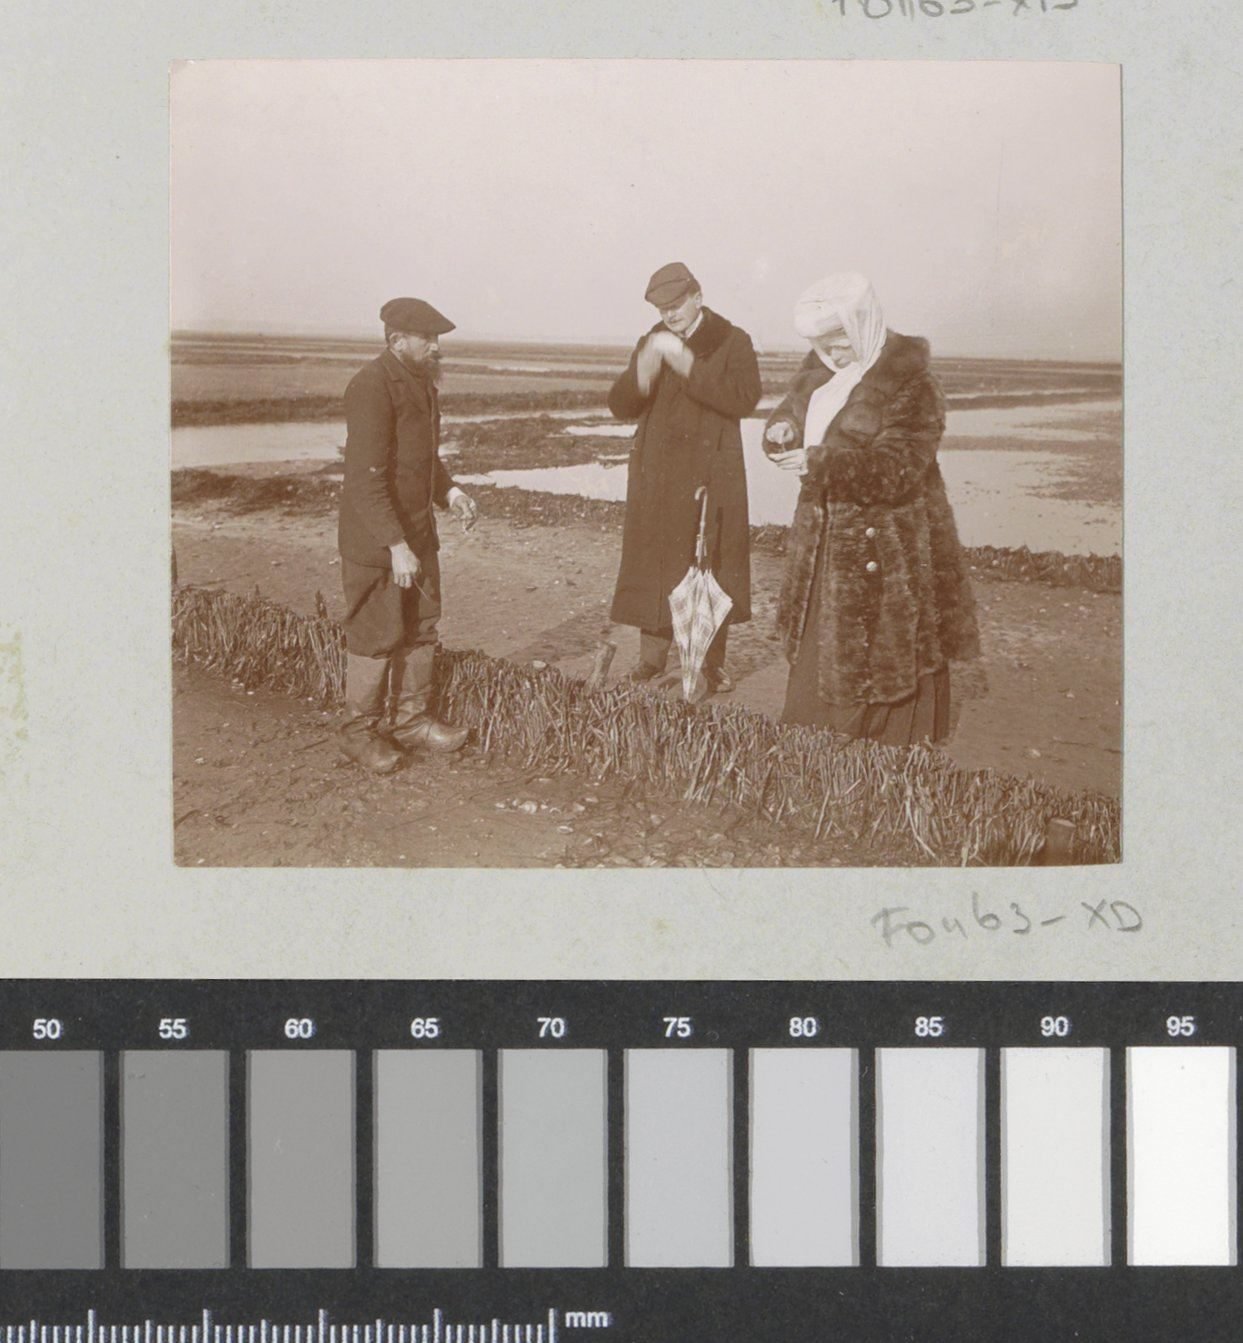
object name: photograph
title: Twee mannen en een vrouw, mogelijk iets proevend op een wad in Frankrijk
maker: delizy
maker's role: manufacturer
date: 1904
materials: paper, photographic support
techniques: gelatin silver print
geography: france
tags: taste, tasting (one of the five senses), mud flat, france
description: Onderdeel van Fotoalbum van een Franse amateurfotograaf met opnames van uitstapjes in Frankrijk, Spanje, België, Luxemburg en Nederland, de eerste automobielen en autoraces.